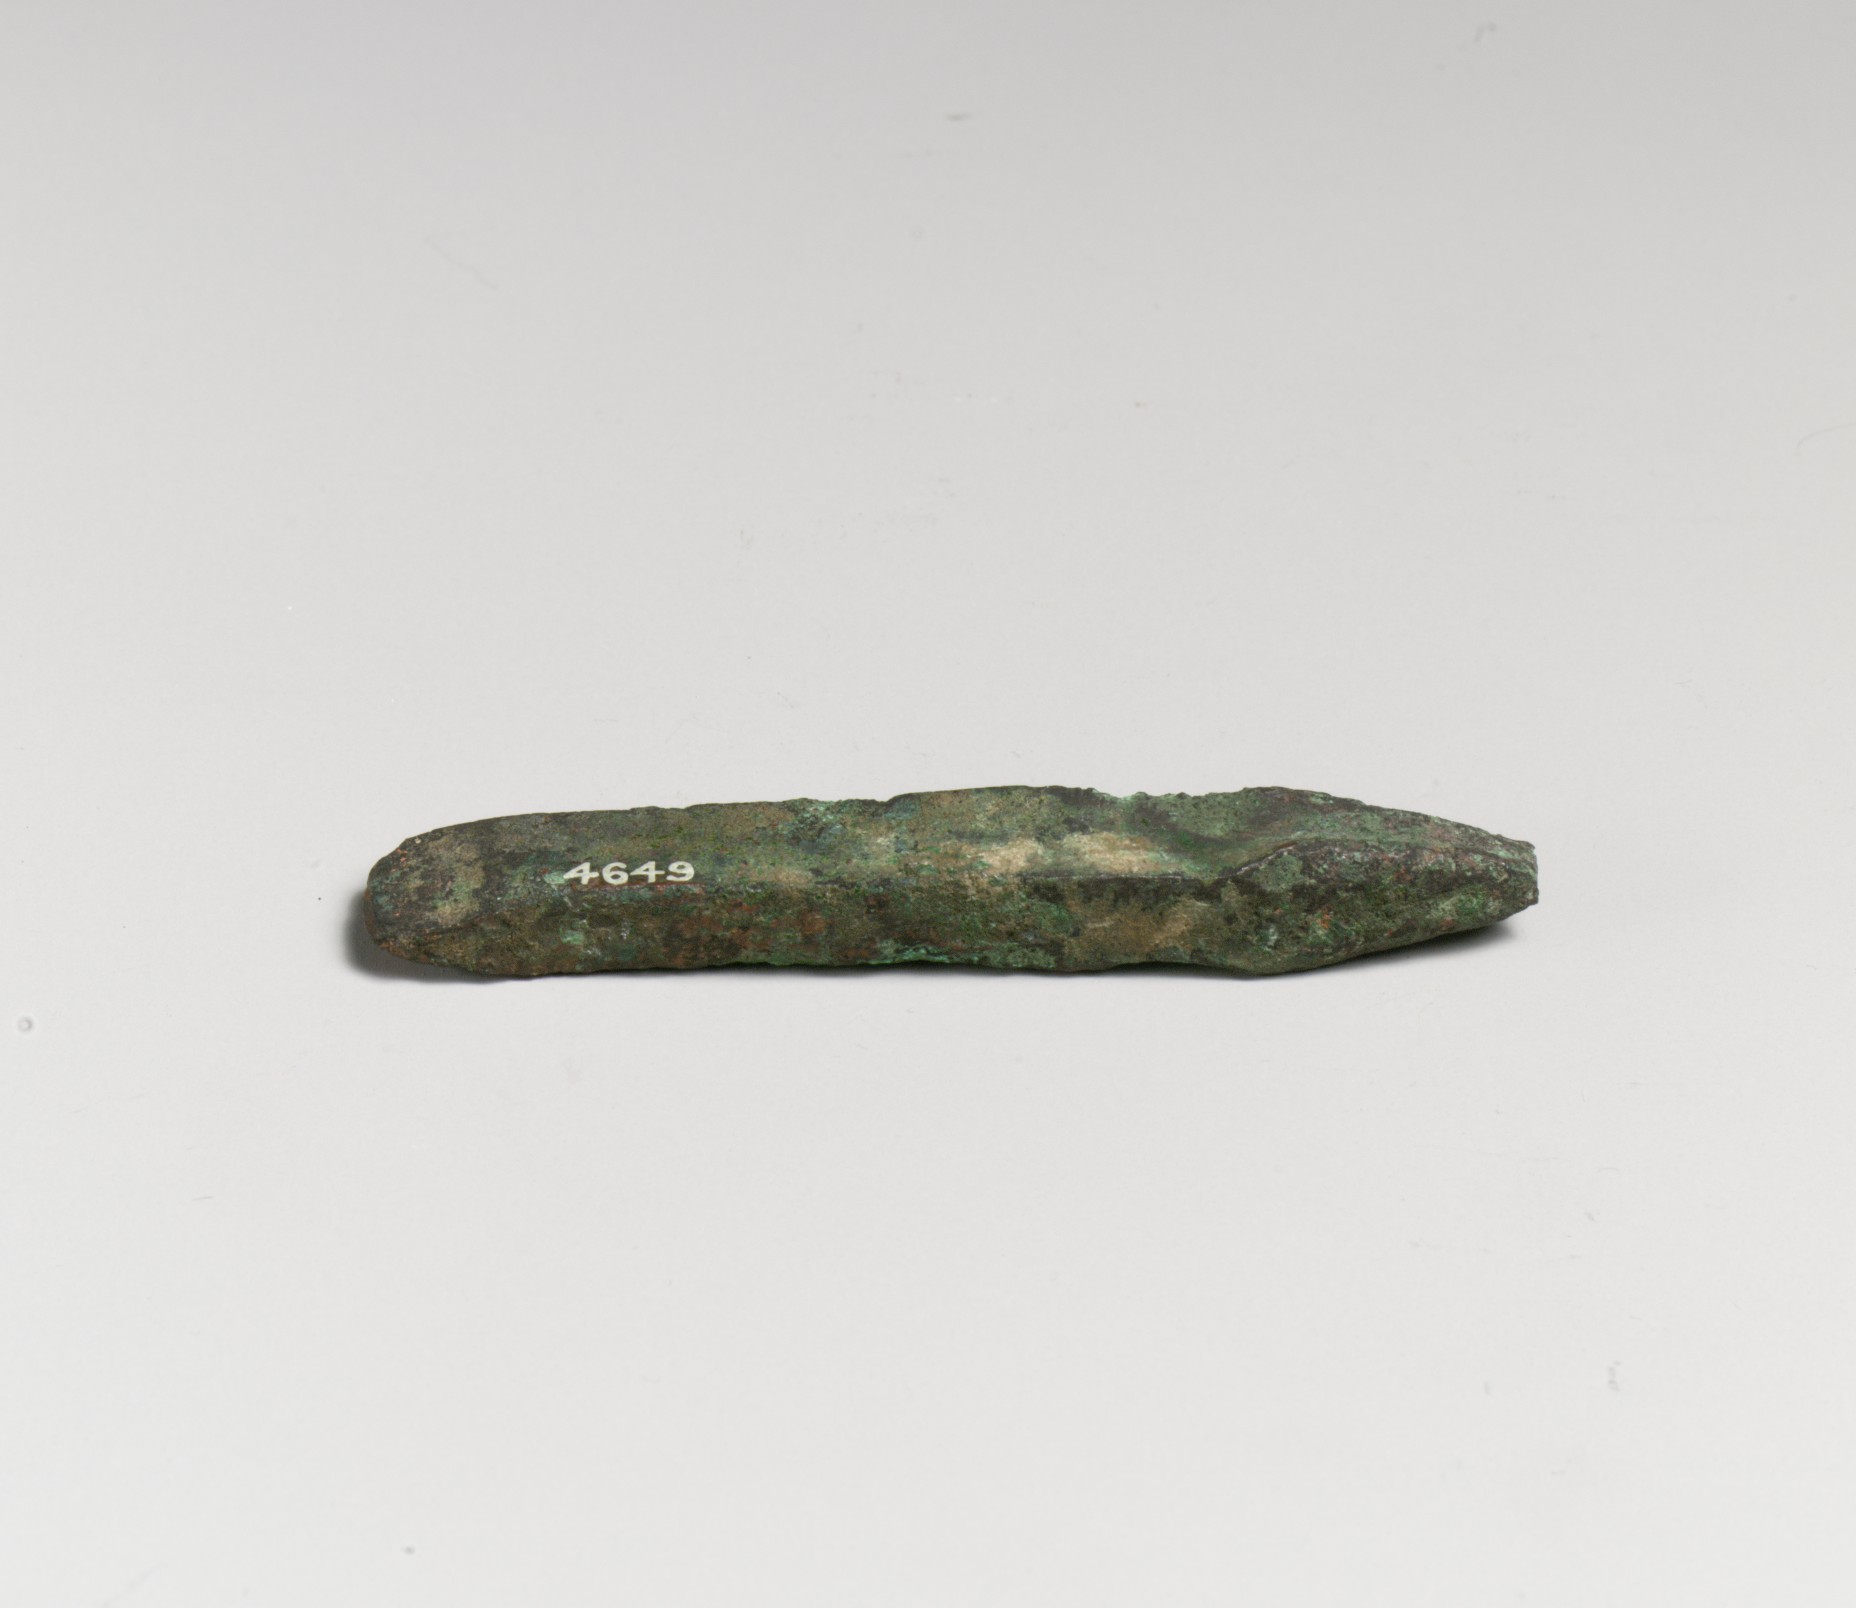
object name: chisel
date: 7000 BCE-330 CE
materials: bronze